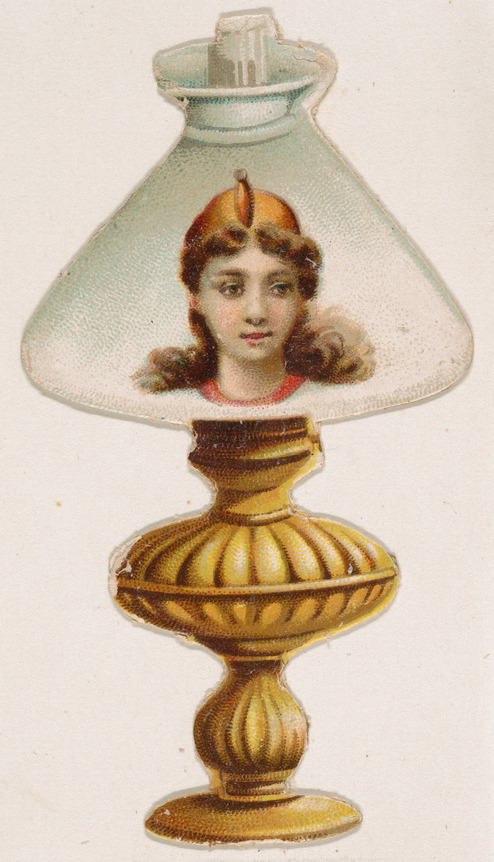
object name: print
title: Lantern, from the Novelties series (N228, Type 3) issued by Kinney Bros.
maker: kinney brothers tobacco company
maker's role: publisher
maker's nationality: american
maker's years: 1869-2011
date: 1889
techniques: color lithograph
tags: women,lanterns